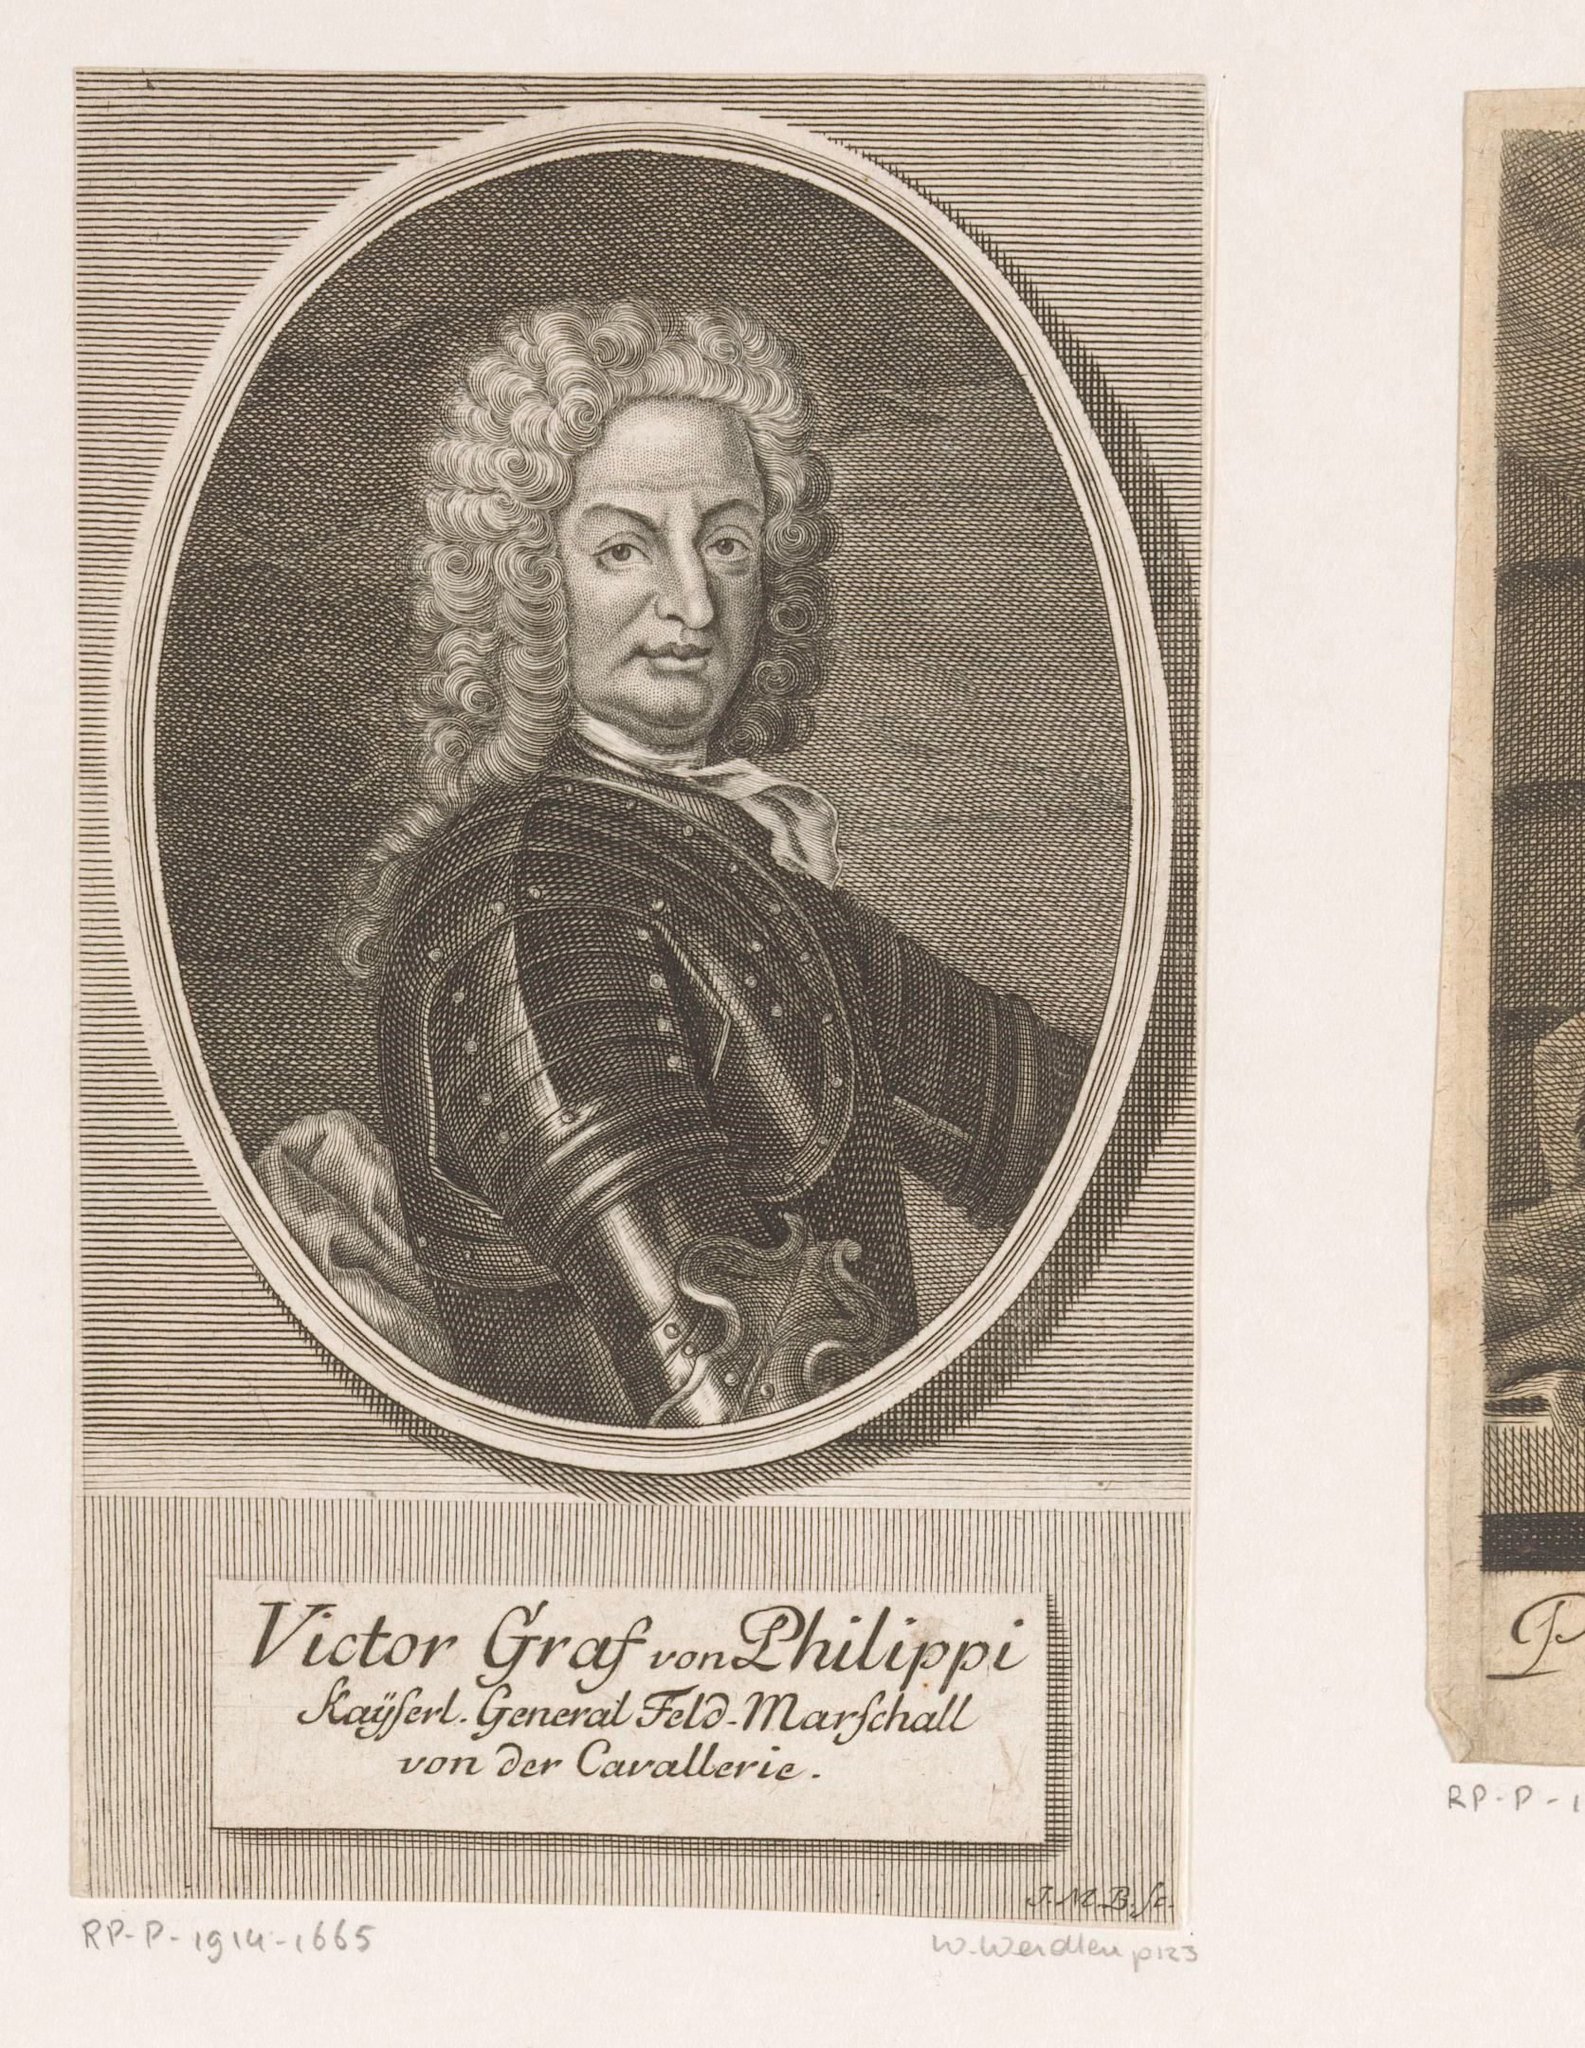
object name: print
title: Portret van Victor Graf von Philippi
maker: johann martin bernigeroth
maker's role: print maker, publisher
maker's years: 1713-1767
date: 1738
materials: paper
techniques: engraving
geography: leipzig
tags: armour, historical persons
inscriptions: collector's mark: Lugt 2228